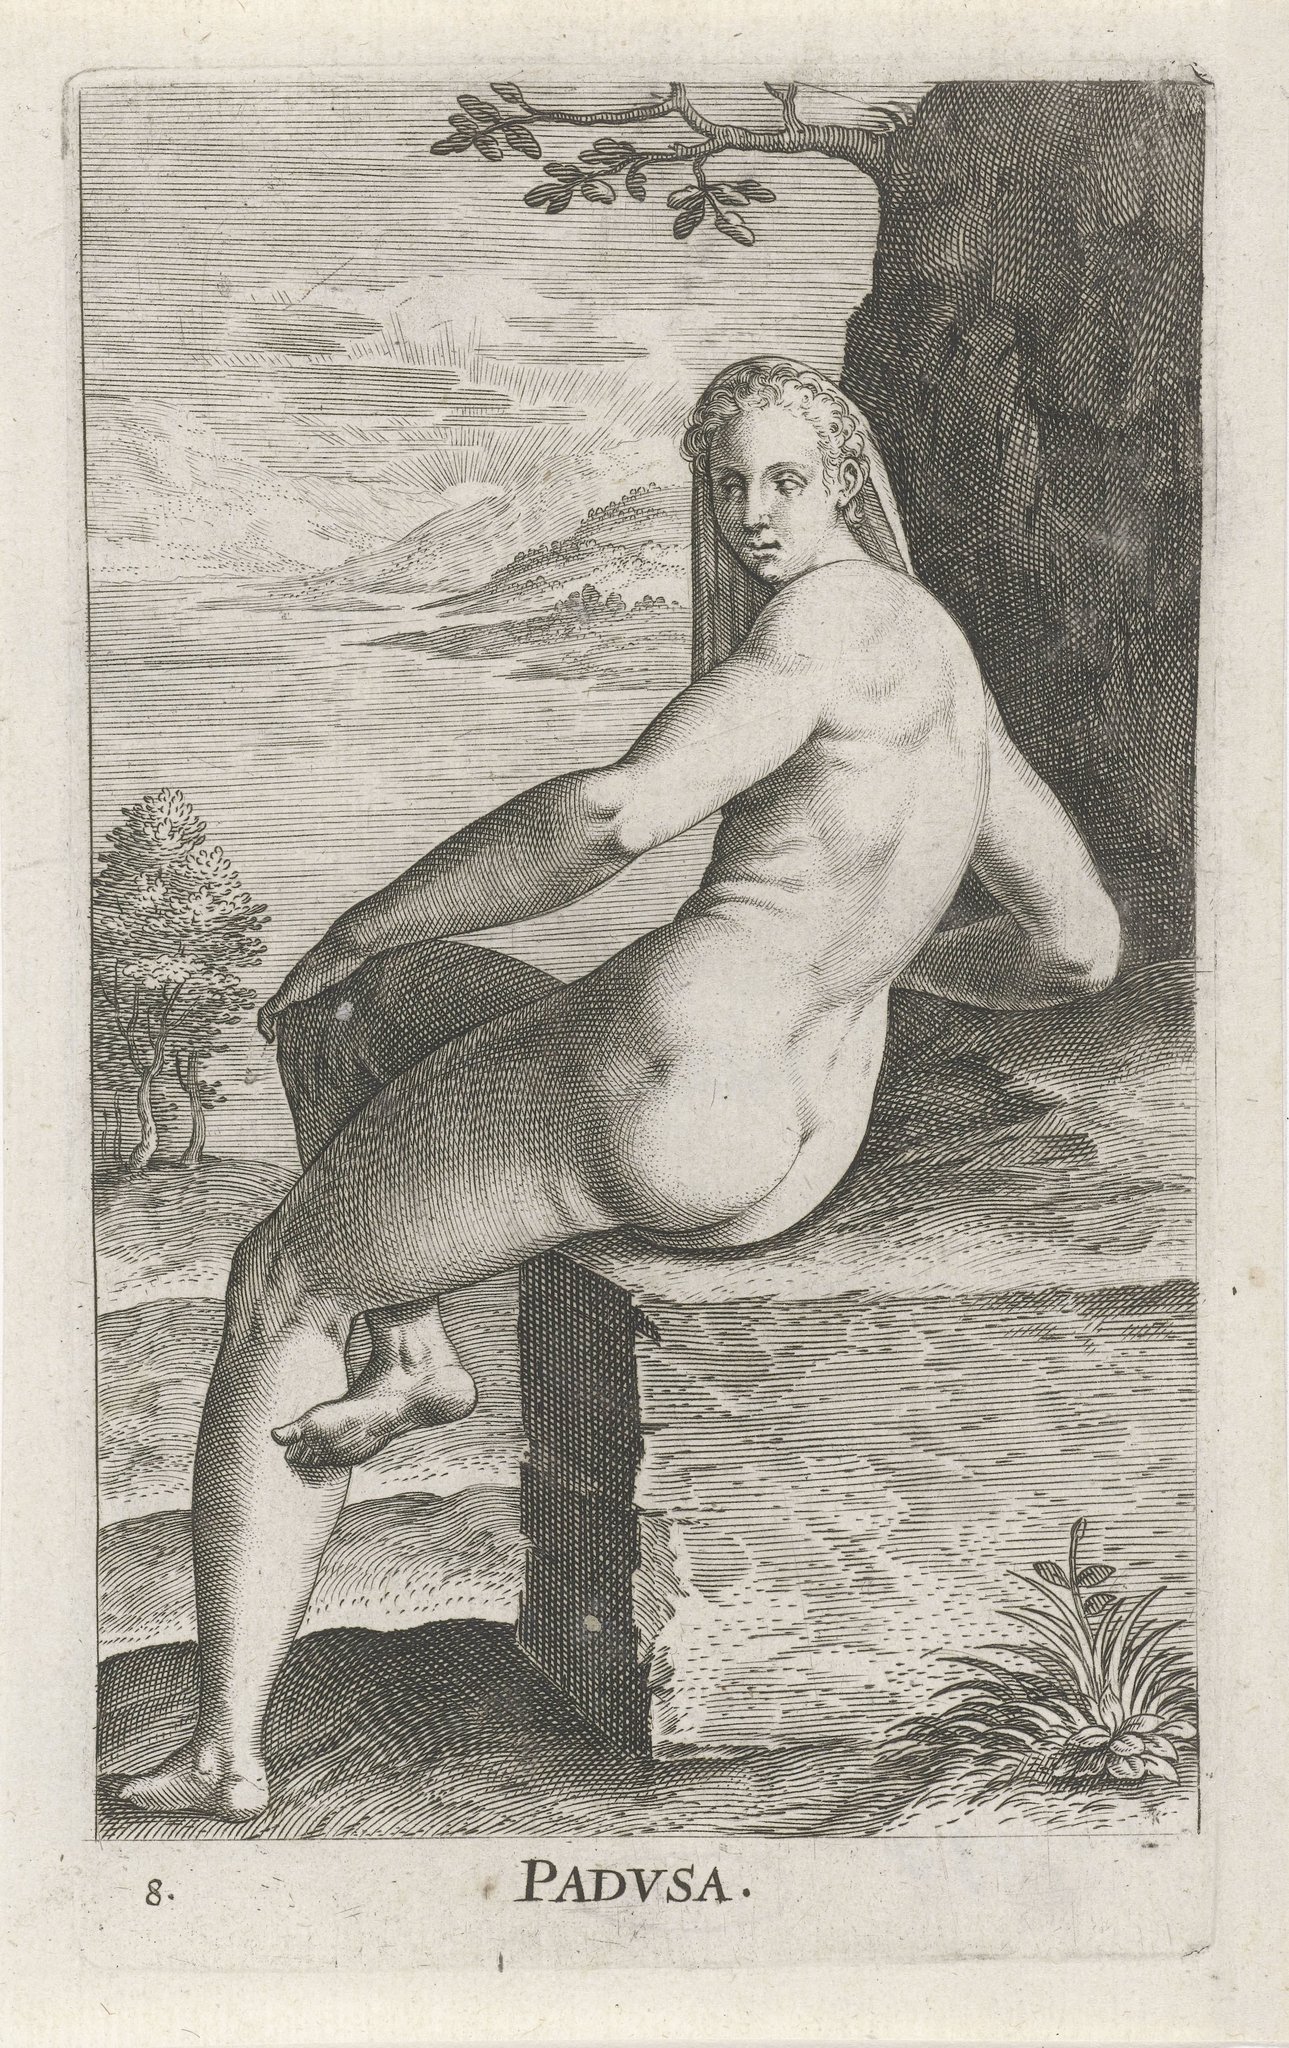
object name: print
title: Waternimf Padusa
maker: philips galle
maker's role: print maker, publisher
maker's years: 1537-1612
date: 1587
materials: paper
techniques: engraving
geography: antwerp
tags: personification of river po; 'po' (ripa)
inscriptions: collector's mark: Lugt 2228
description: De waternimf Padusa (de rivier de Po), gezeten op een stenen blok. De prent maakt deel uit van een zeventiendelige serie over stroom- en waternimfen.